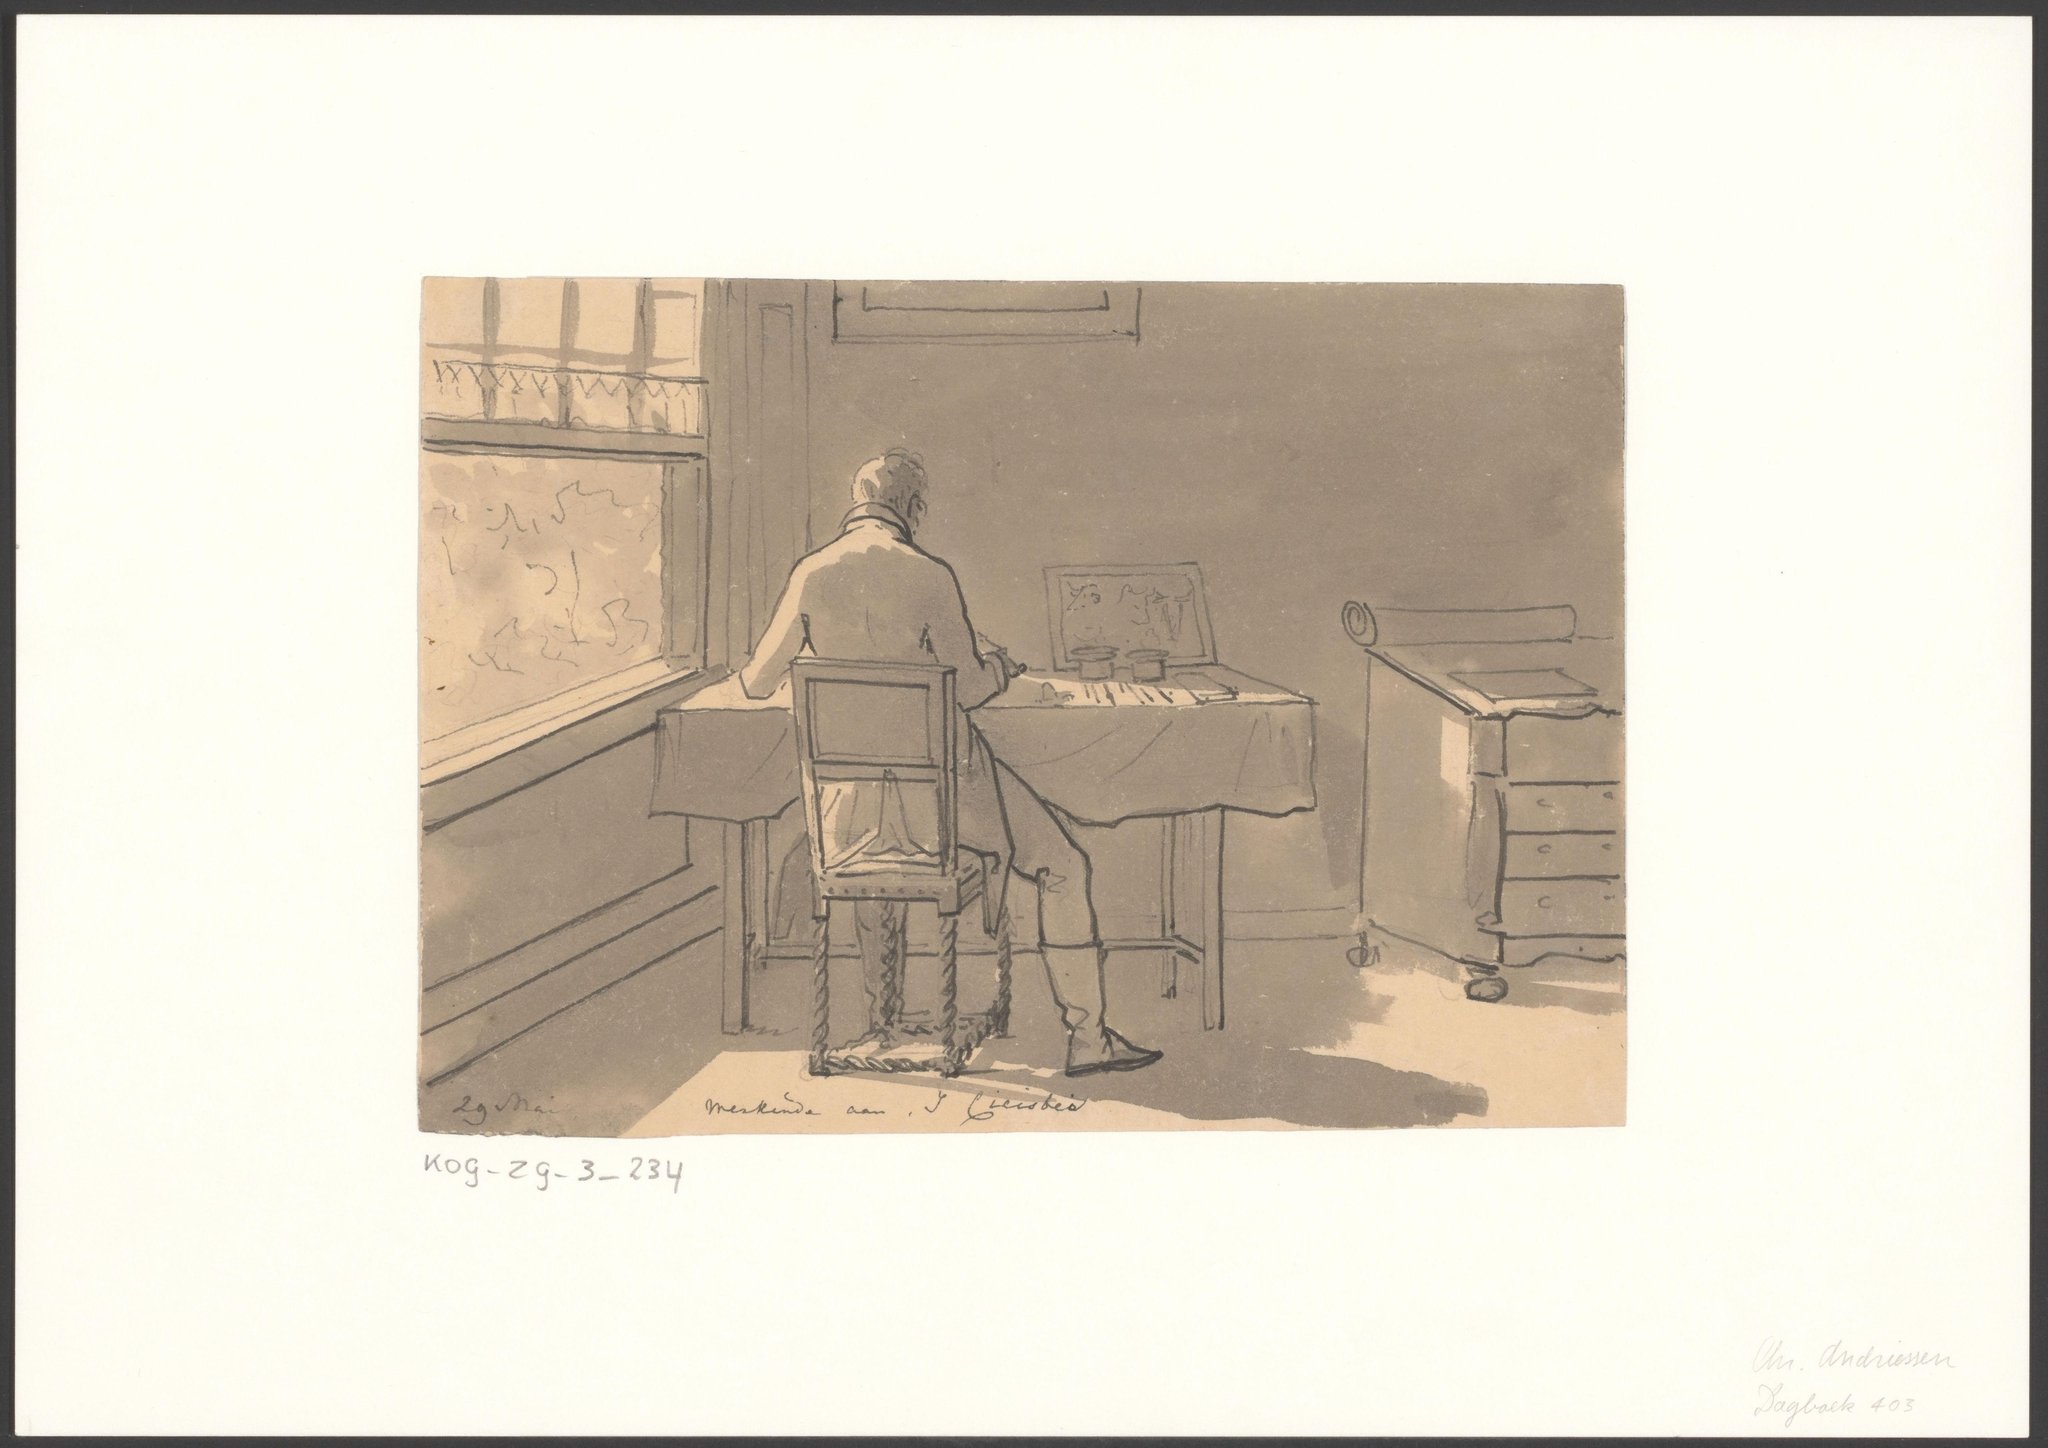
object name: drawing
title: Christiaan Andriessen zit te tekenen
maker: christiaan andriessen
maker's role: draughtsman, print maker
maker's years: 1775-1846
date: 1805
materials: ink, paper, pencil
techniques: brush, pen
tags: print maker, draughtsman, christiaan andriessen, drawing, sketch, workshop, studio ~ painter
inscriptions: signature: ‘J Andriessen’, inscription: ‘29 Mai werkende aan I Cicisbei’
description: Dagboekblad uit het getekende dagboek dat Christiaan Andriessen bijhield van 1805 tot en met 1808.